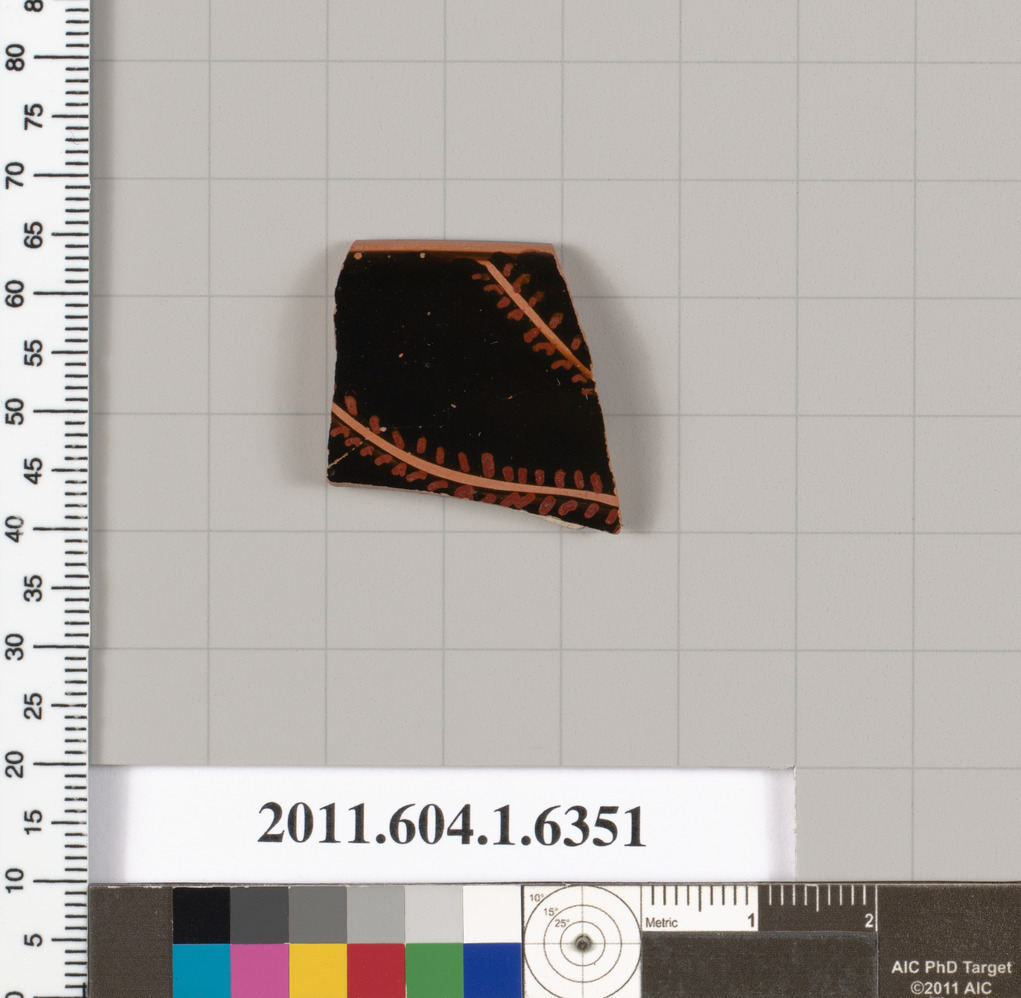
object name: kylix fragment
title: Terracotta rim fragment of a kylix (drinking cup)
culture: greek, attic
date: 500-480 BCE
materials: terracotta